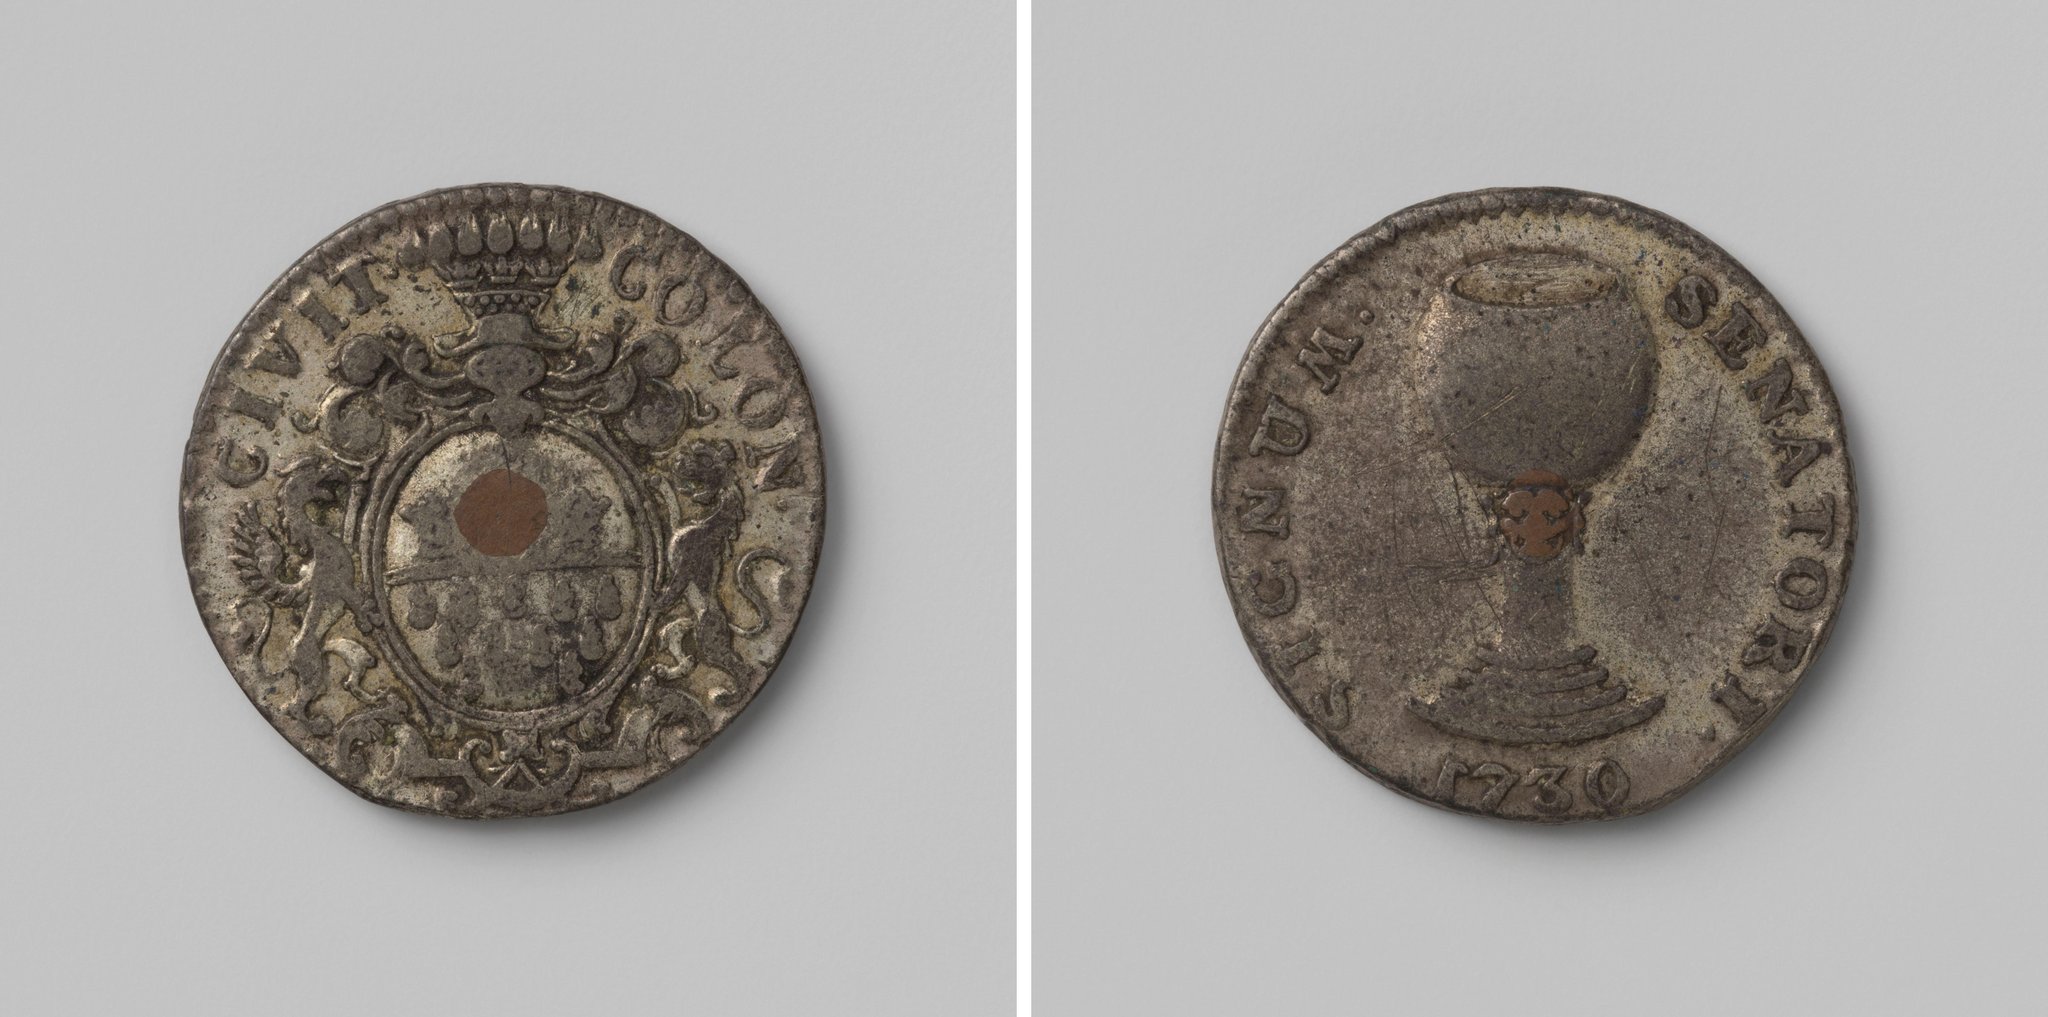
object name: council medal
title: Vroedschapspenning van de stad Keulen, penning uitgereikt aan de leden van de stadsraad recht gevend op een kan bier of wijn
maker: Anonymous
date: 1730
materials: metal alloy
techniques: striking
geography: cologne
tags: cologne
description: Penning. Voorzijde: gehelmd wapenschild, geflankeerd door griffioen en leeuw binnen omschrift. Keerzijde: kelk met op voet een gezichtje binnen omschrift; randschrift